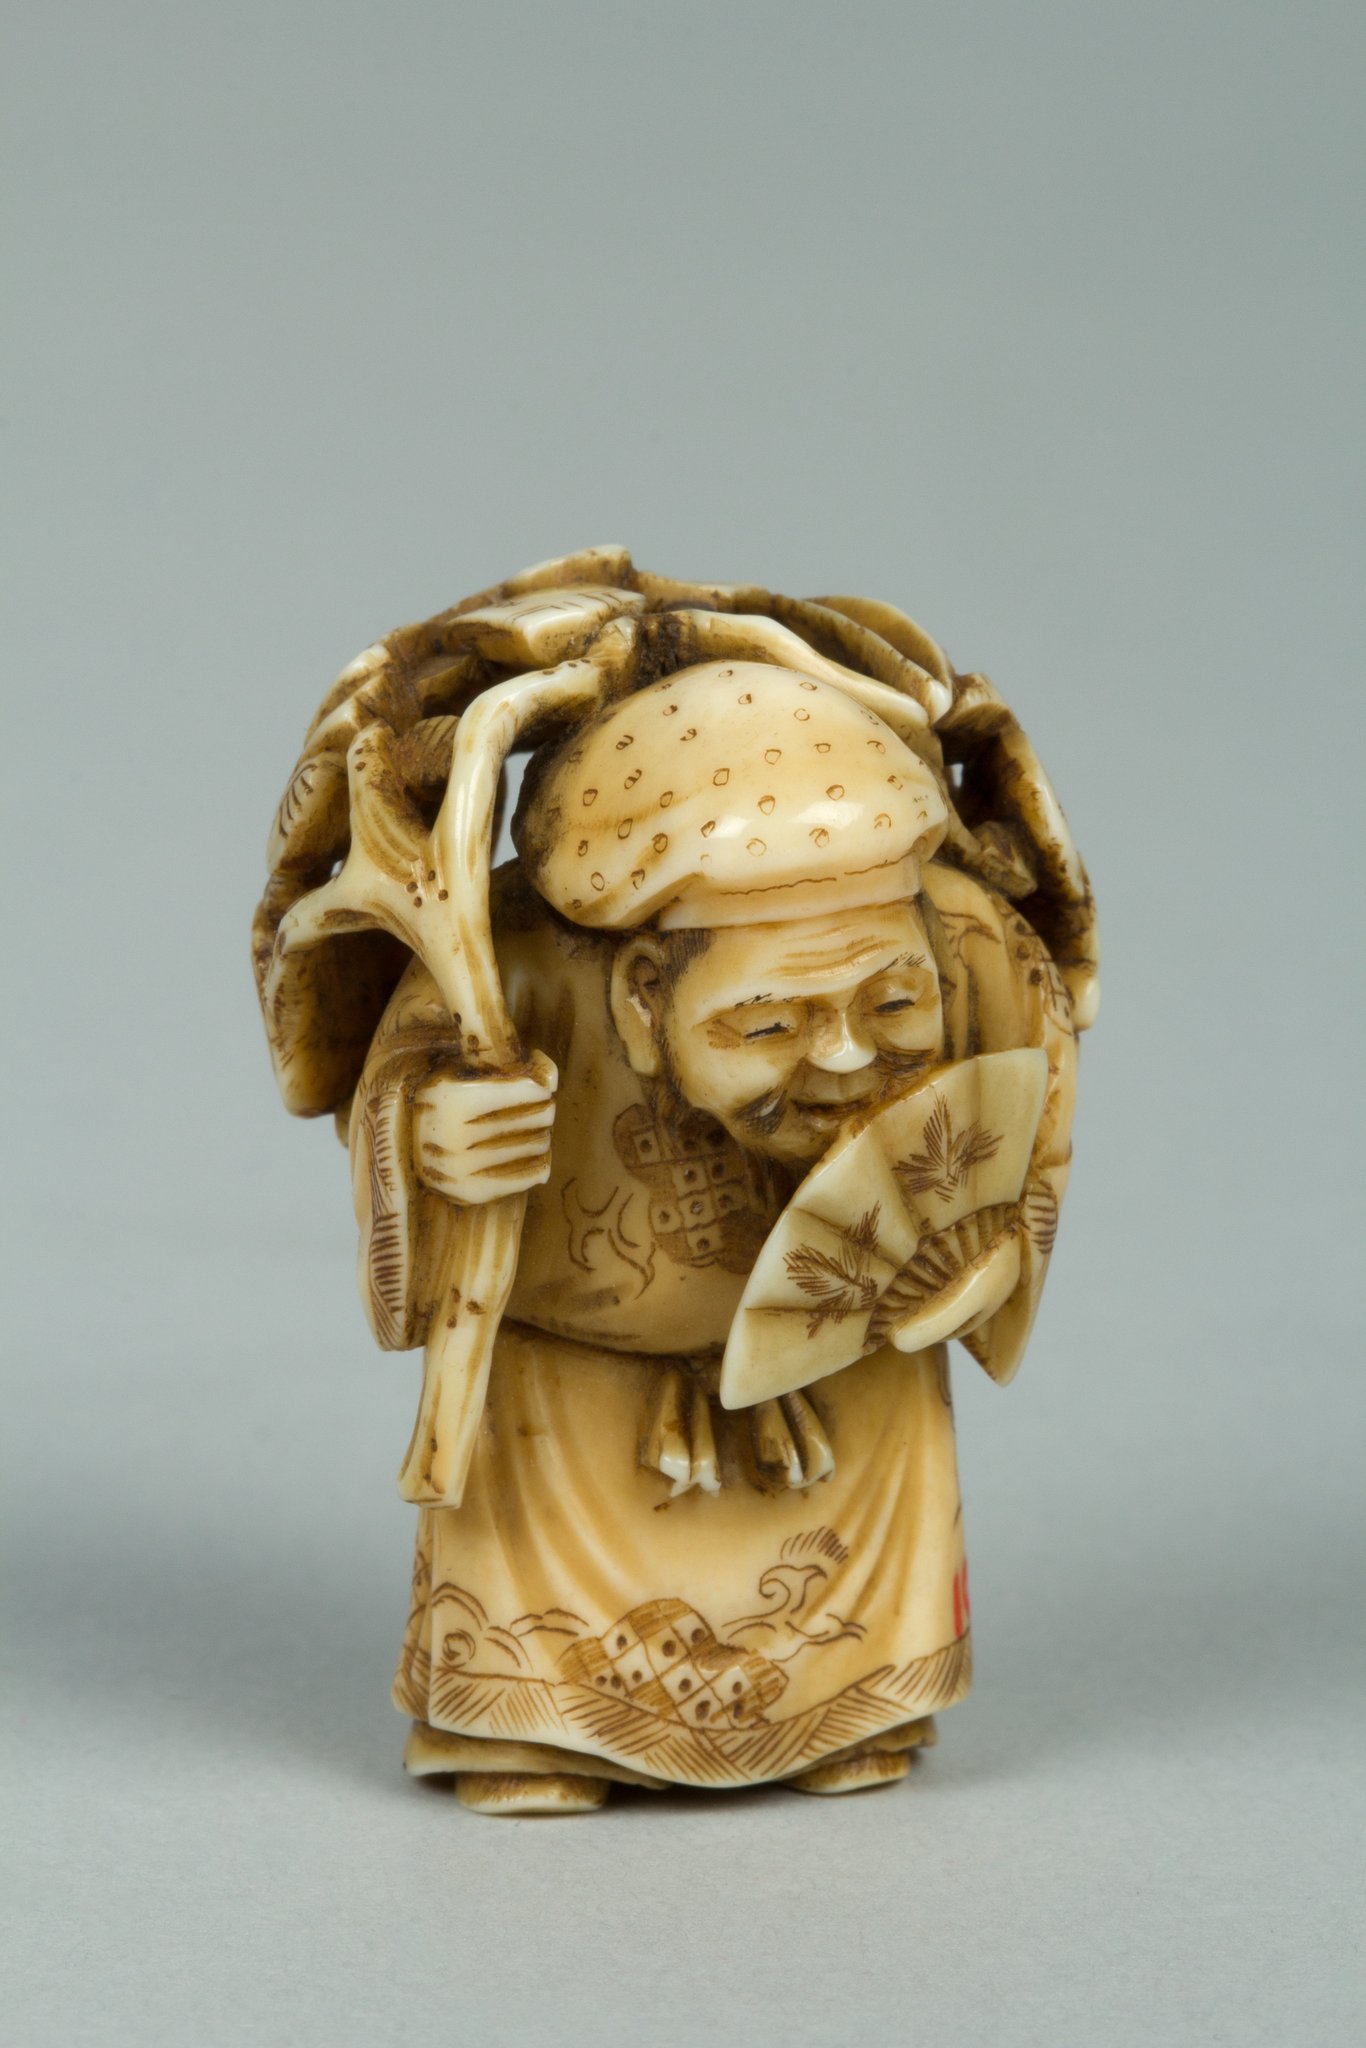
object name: netsuke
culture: japanese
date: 1801-1900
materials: ivory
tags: fans,men